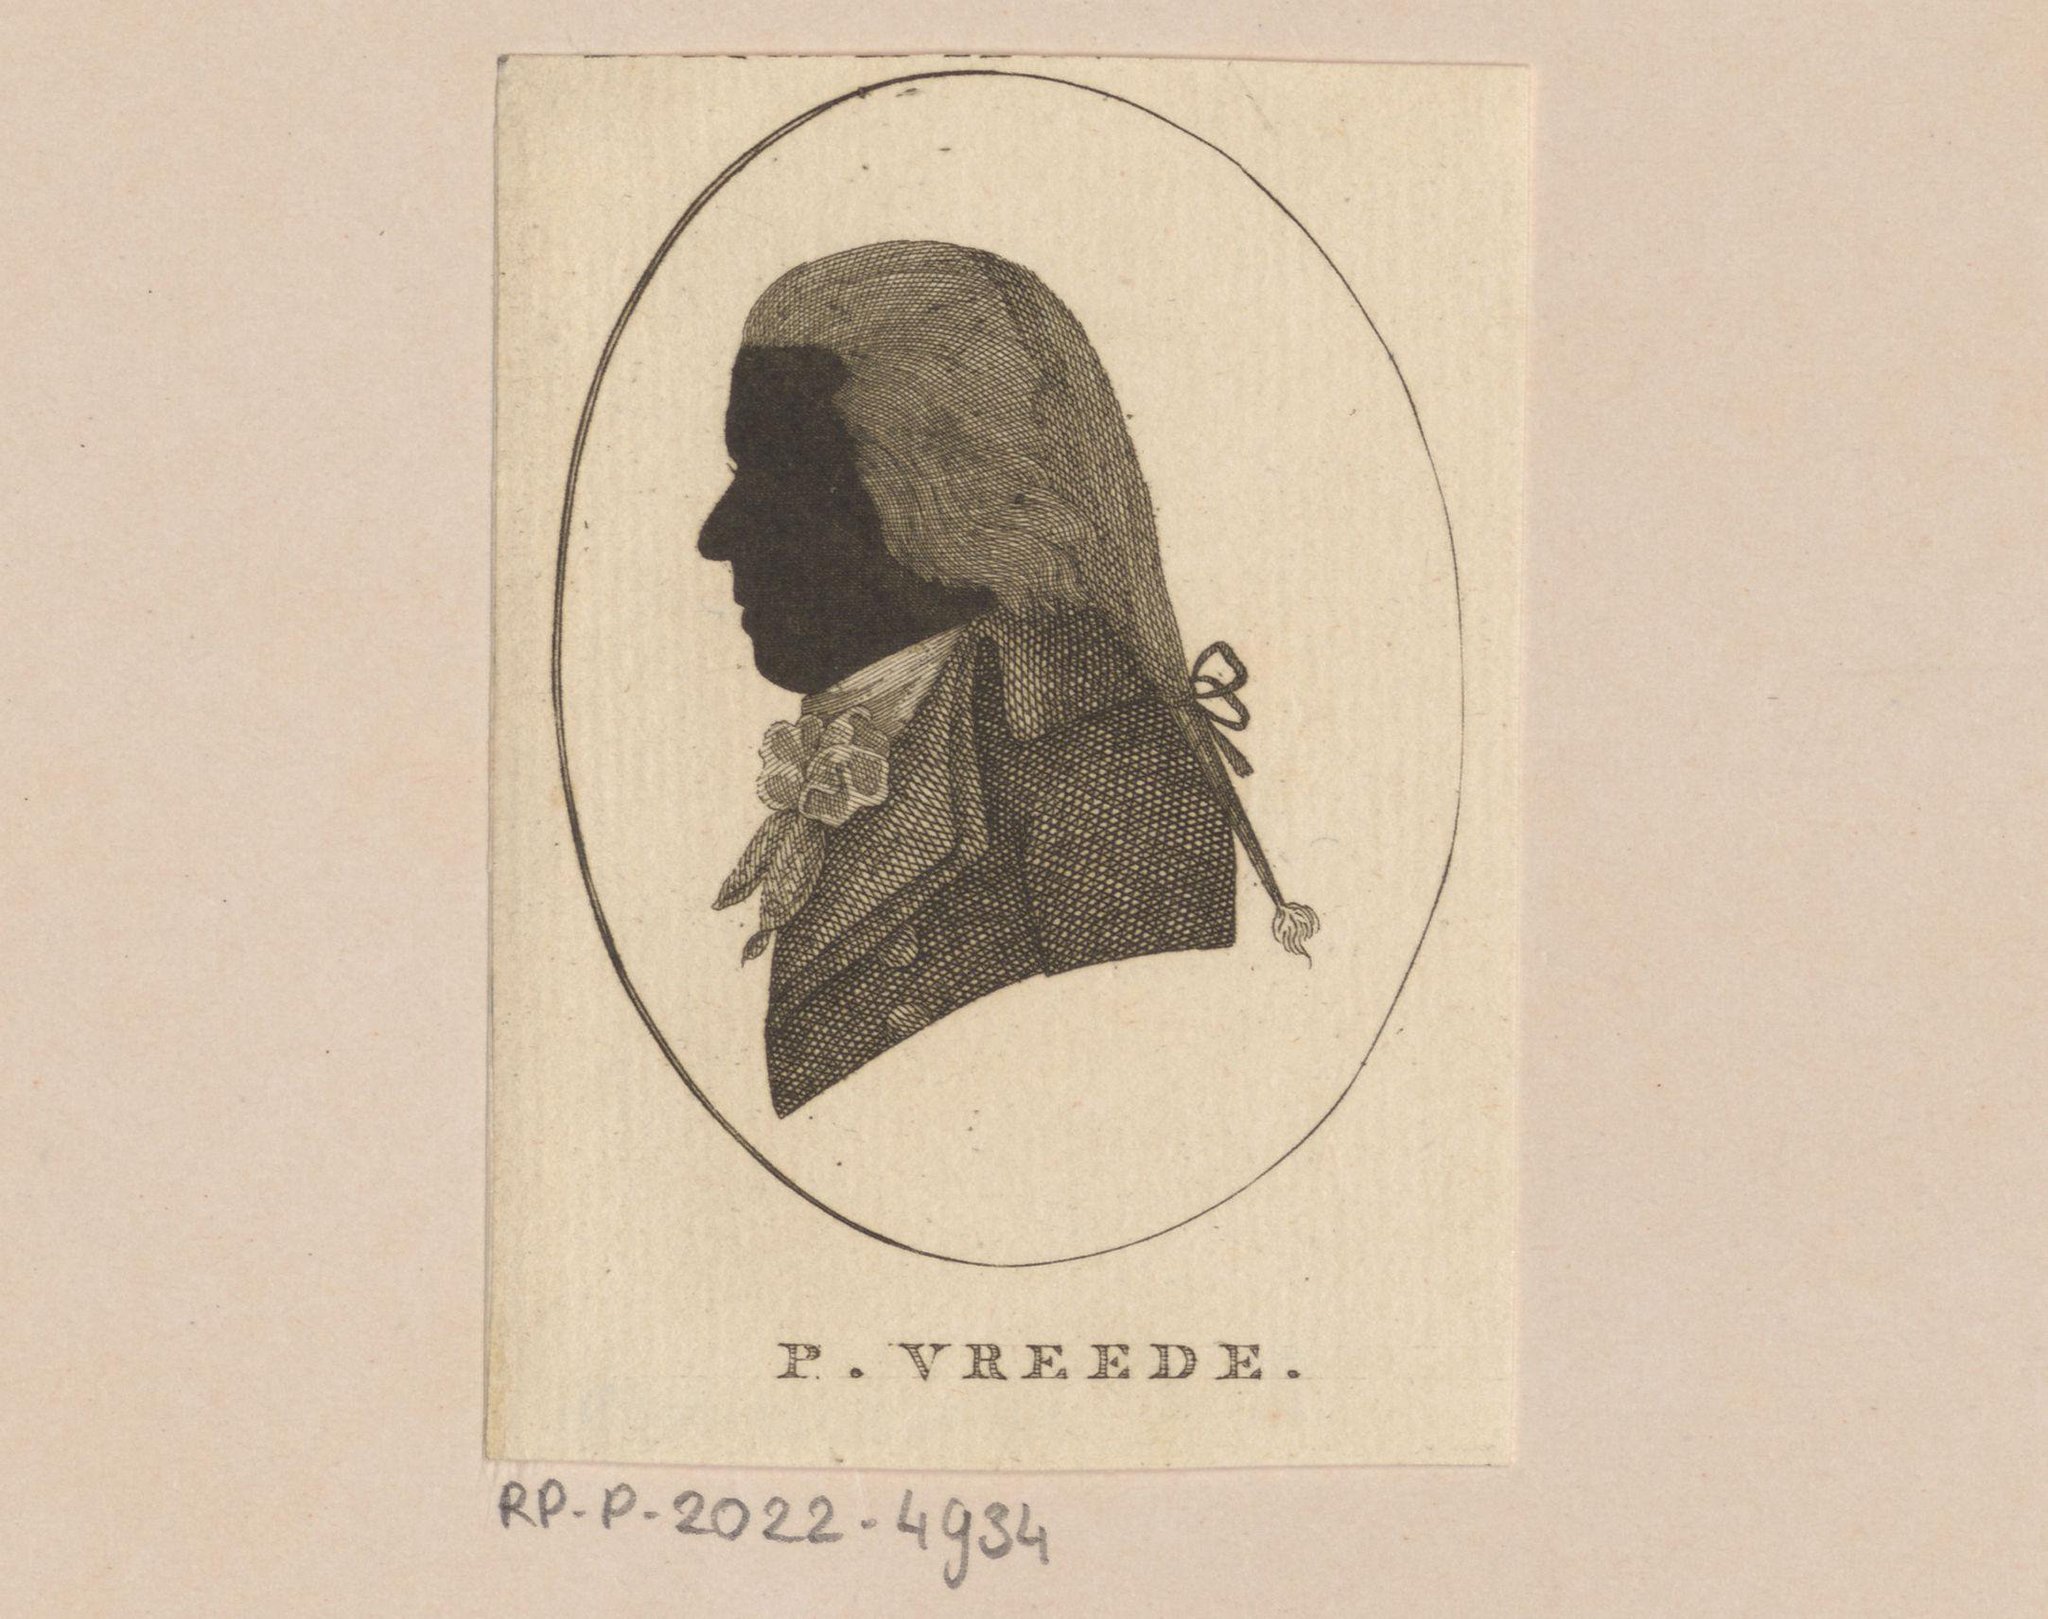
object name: print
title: Silhouetportret van Pieter Vreede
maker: Anonymous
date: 1799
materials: paper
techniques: etching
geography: netherlands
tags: leiden, pieter vreede, historical persons, portrait of a writer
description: Prent waarschijnlijk uit: Rogge, Cornelis. Geschiedenis der staatsregeling, voor het Bataafsche volk, Amsterdam 1799.